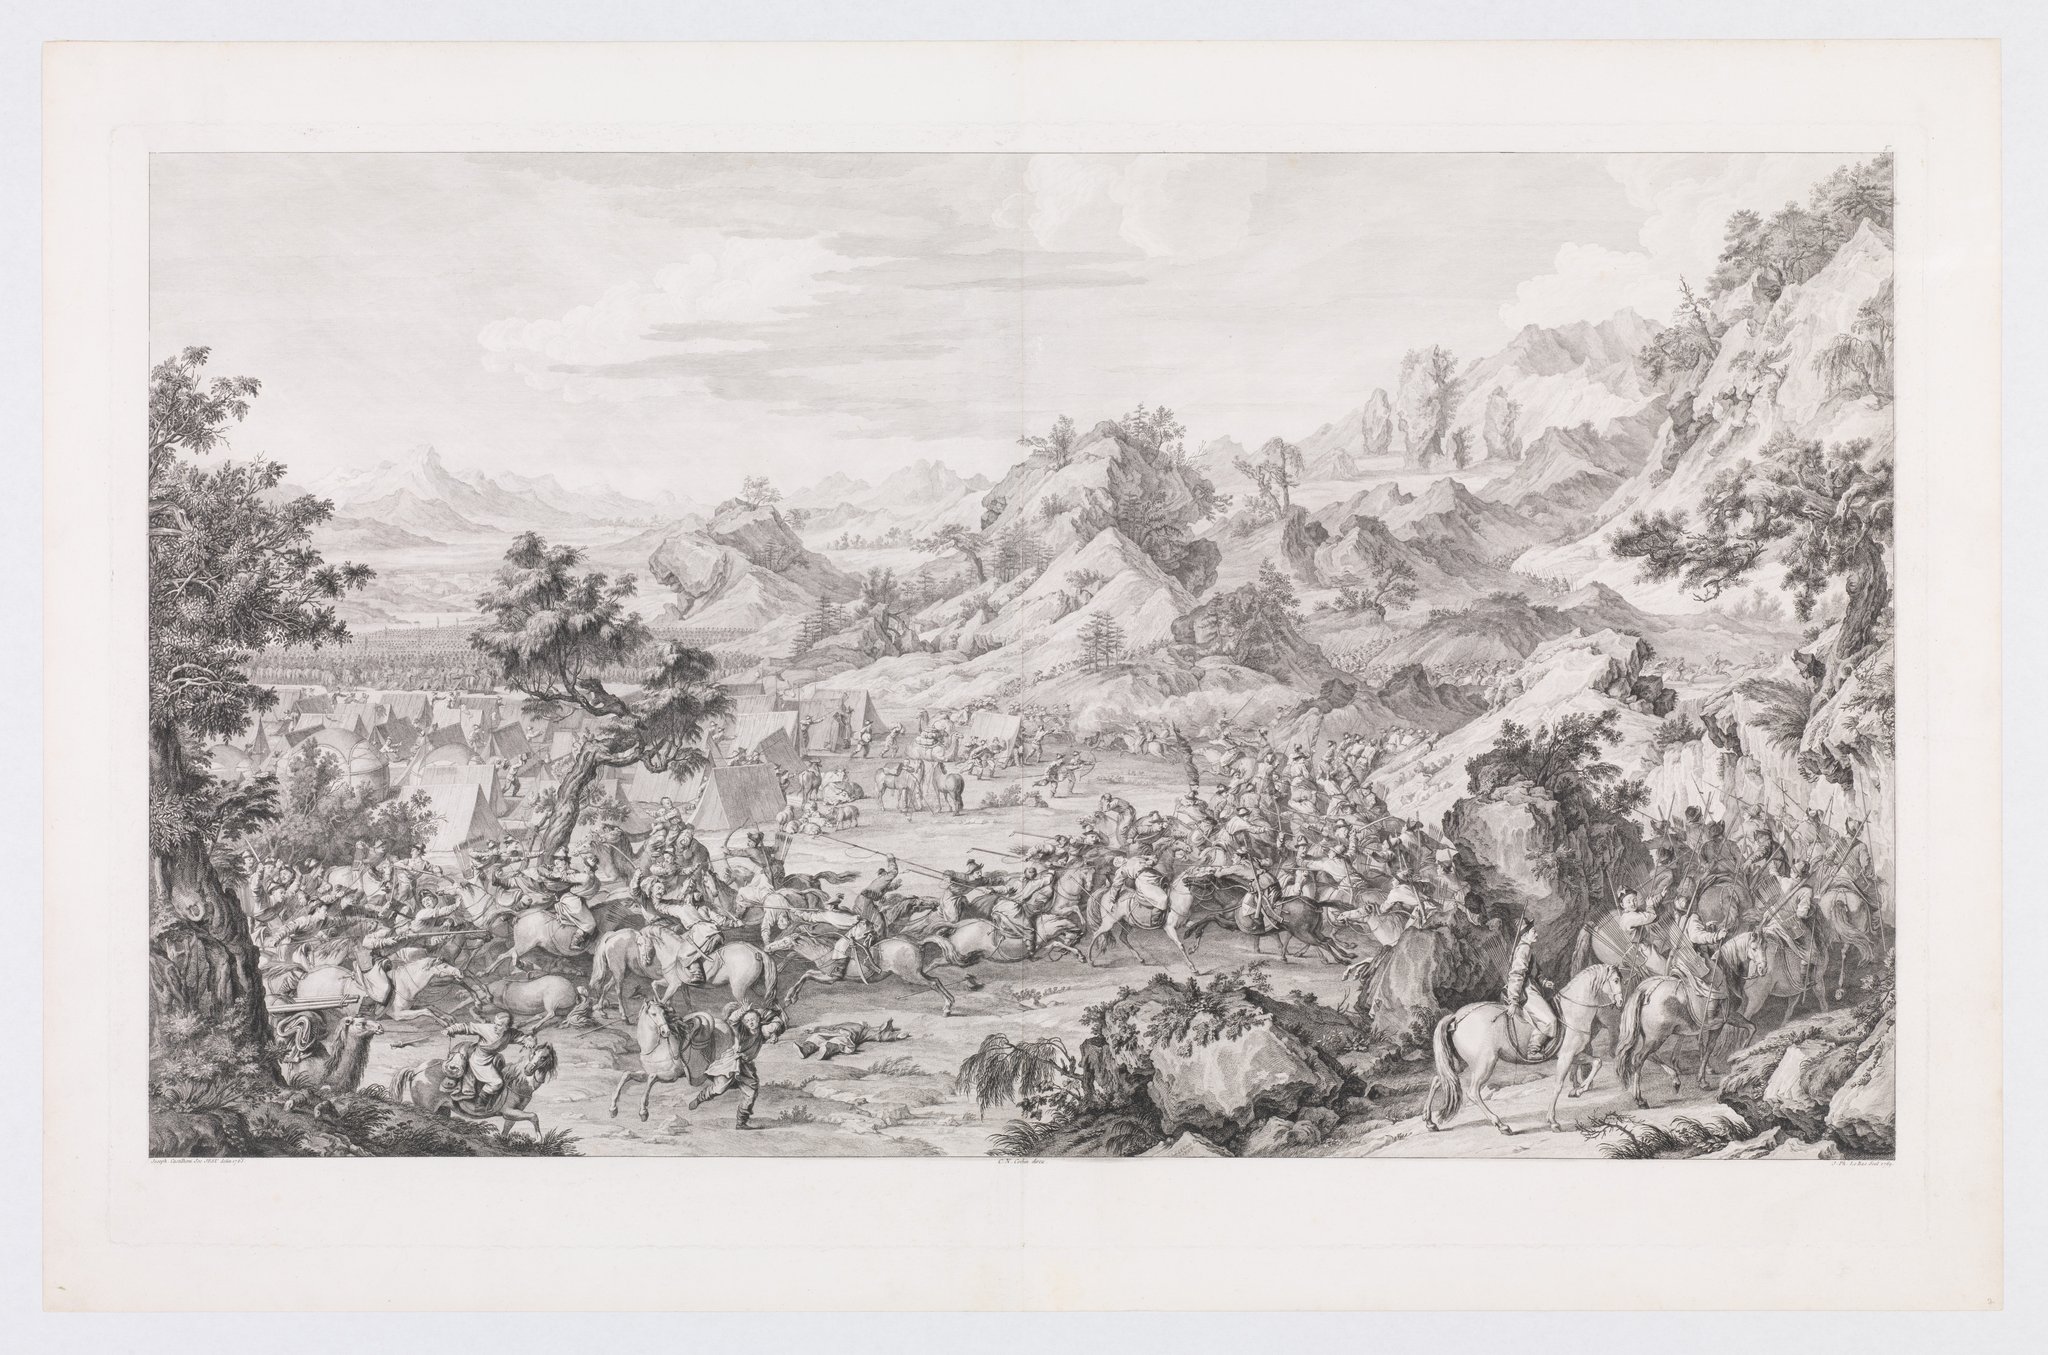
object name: print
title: Storming the Camp at Mount Gadan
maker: jacques philippe le bas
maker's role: artist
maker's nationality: french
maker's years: 1707-1783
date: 1769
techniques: engraving, etching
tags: human figures,horses,mountains,landscapes